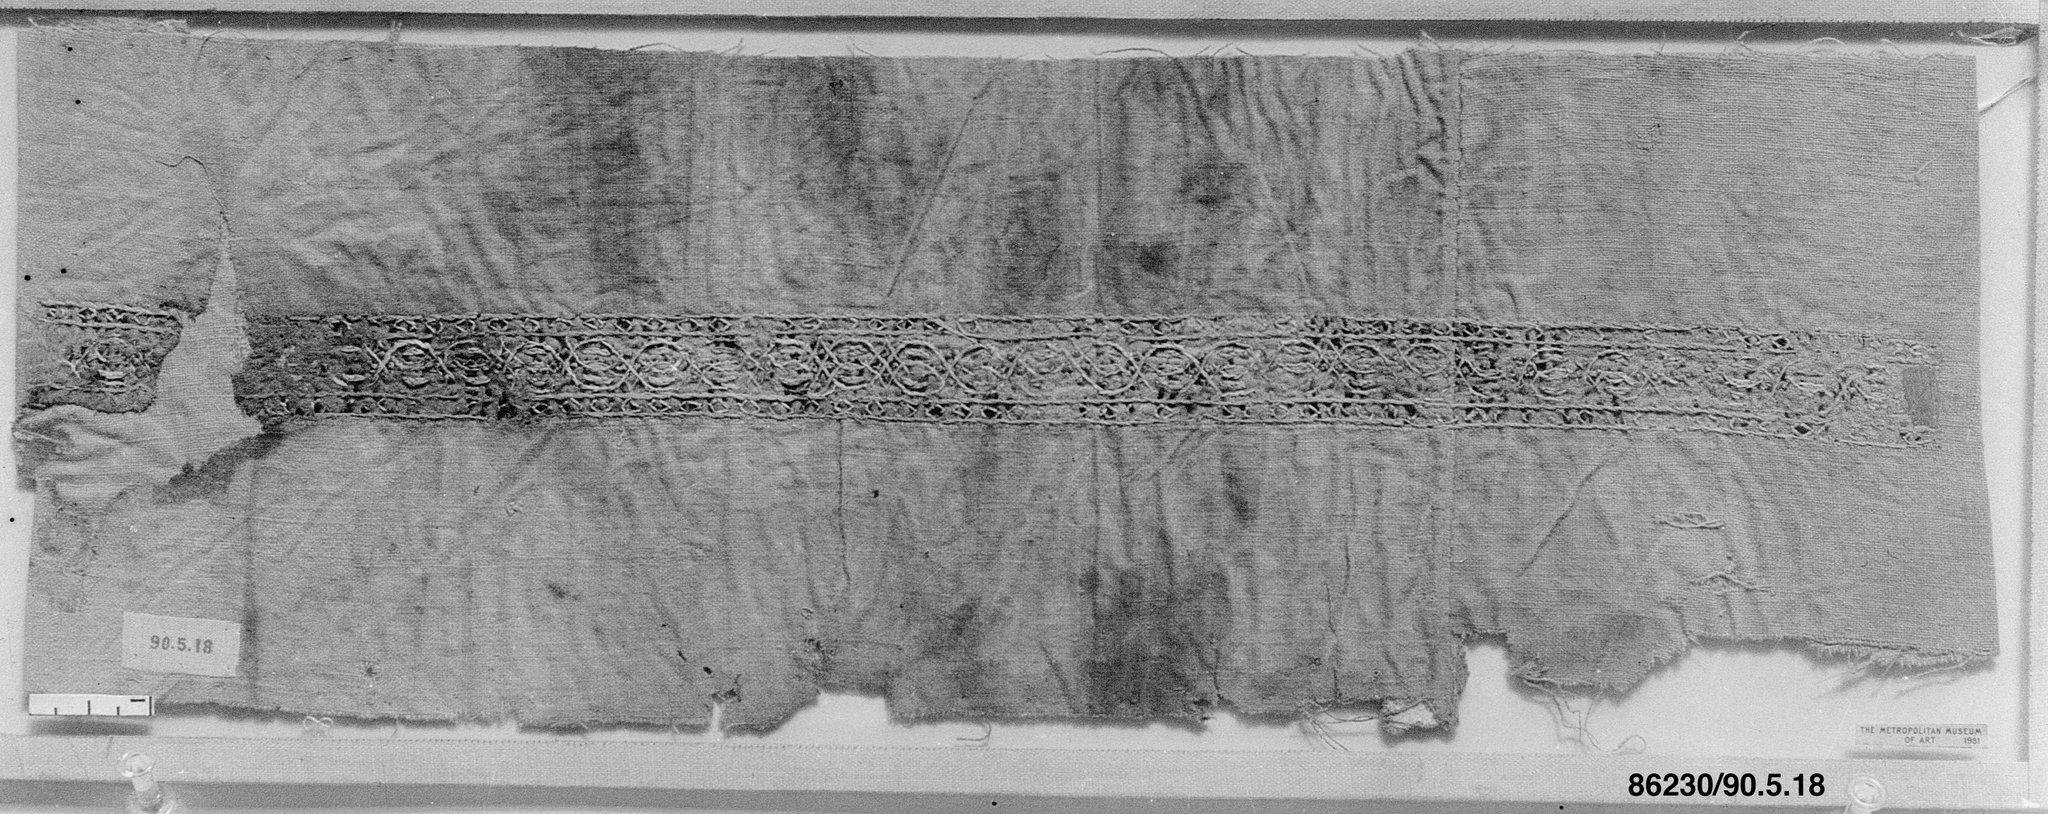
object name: textile fragment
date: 901-1100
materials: linen, silk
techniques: embroidery, weave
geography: egypt